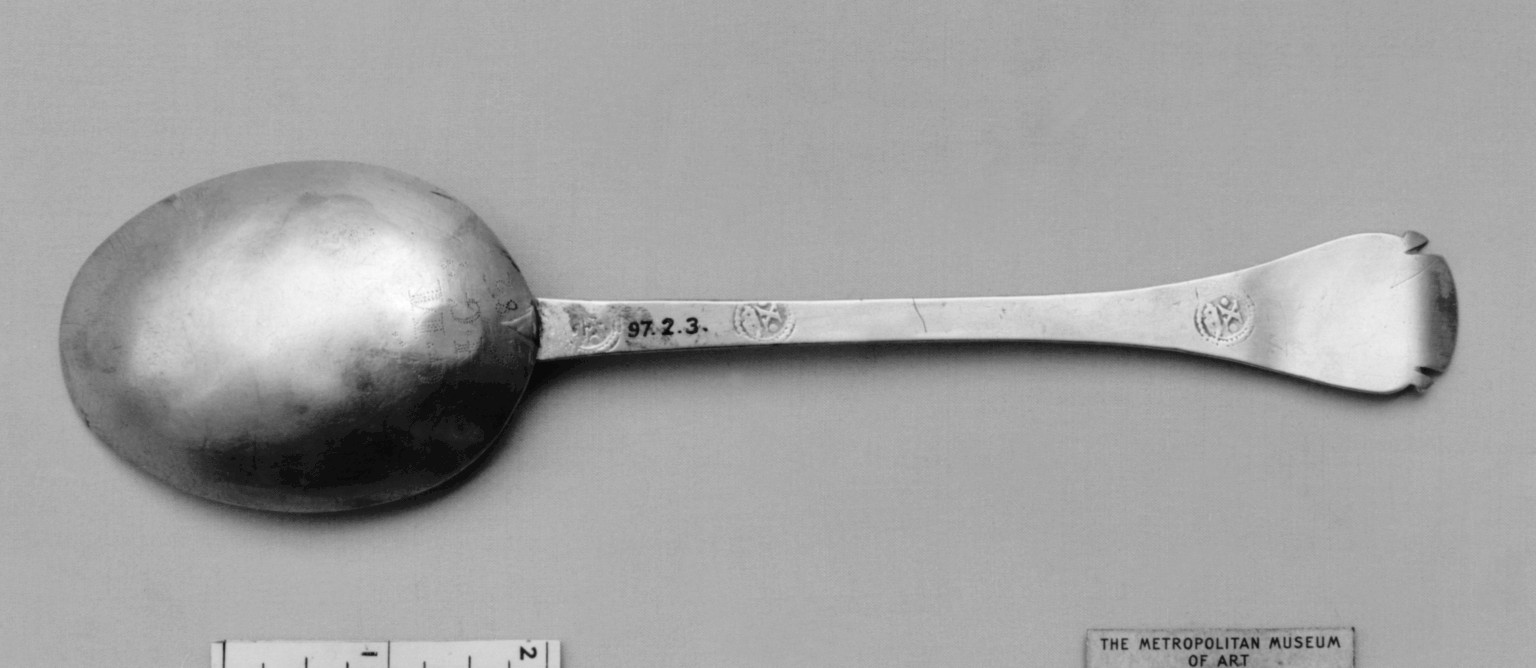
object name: trifid spoon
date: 1660-1670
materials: silver